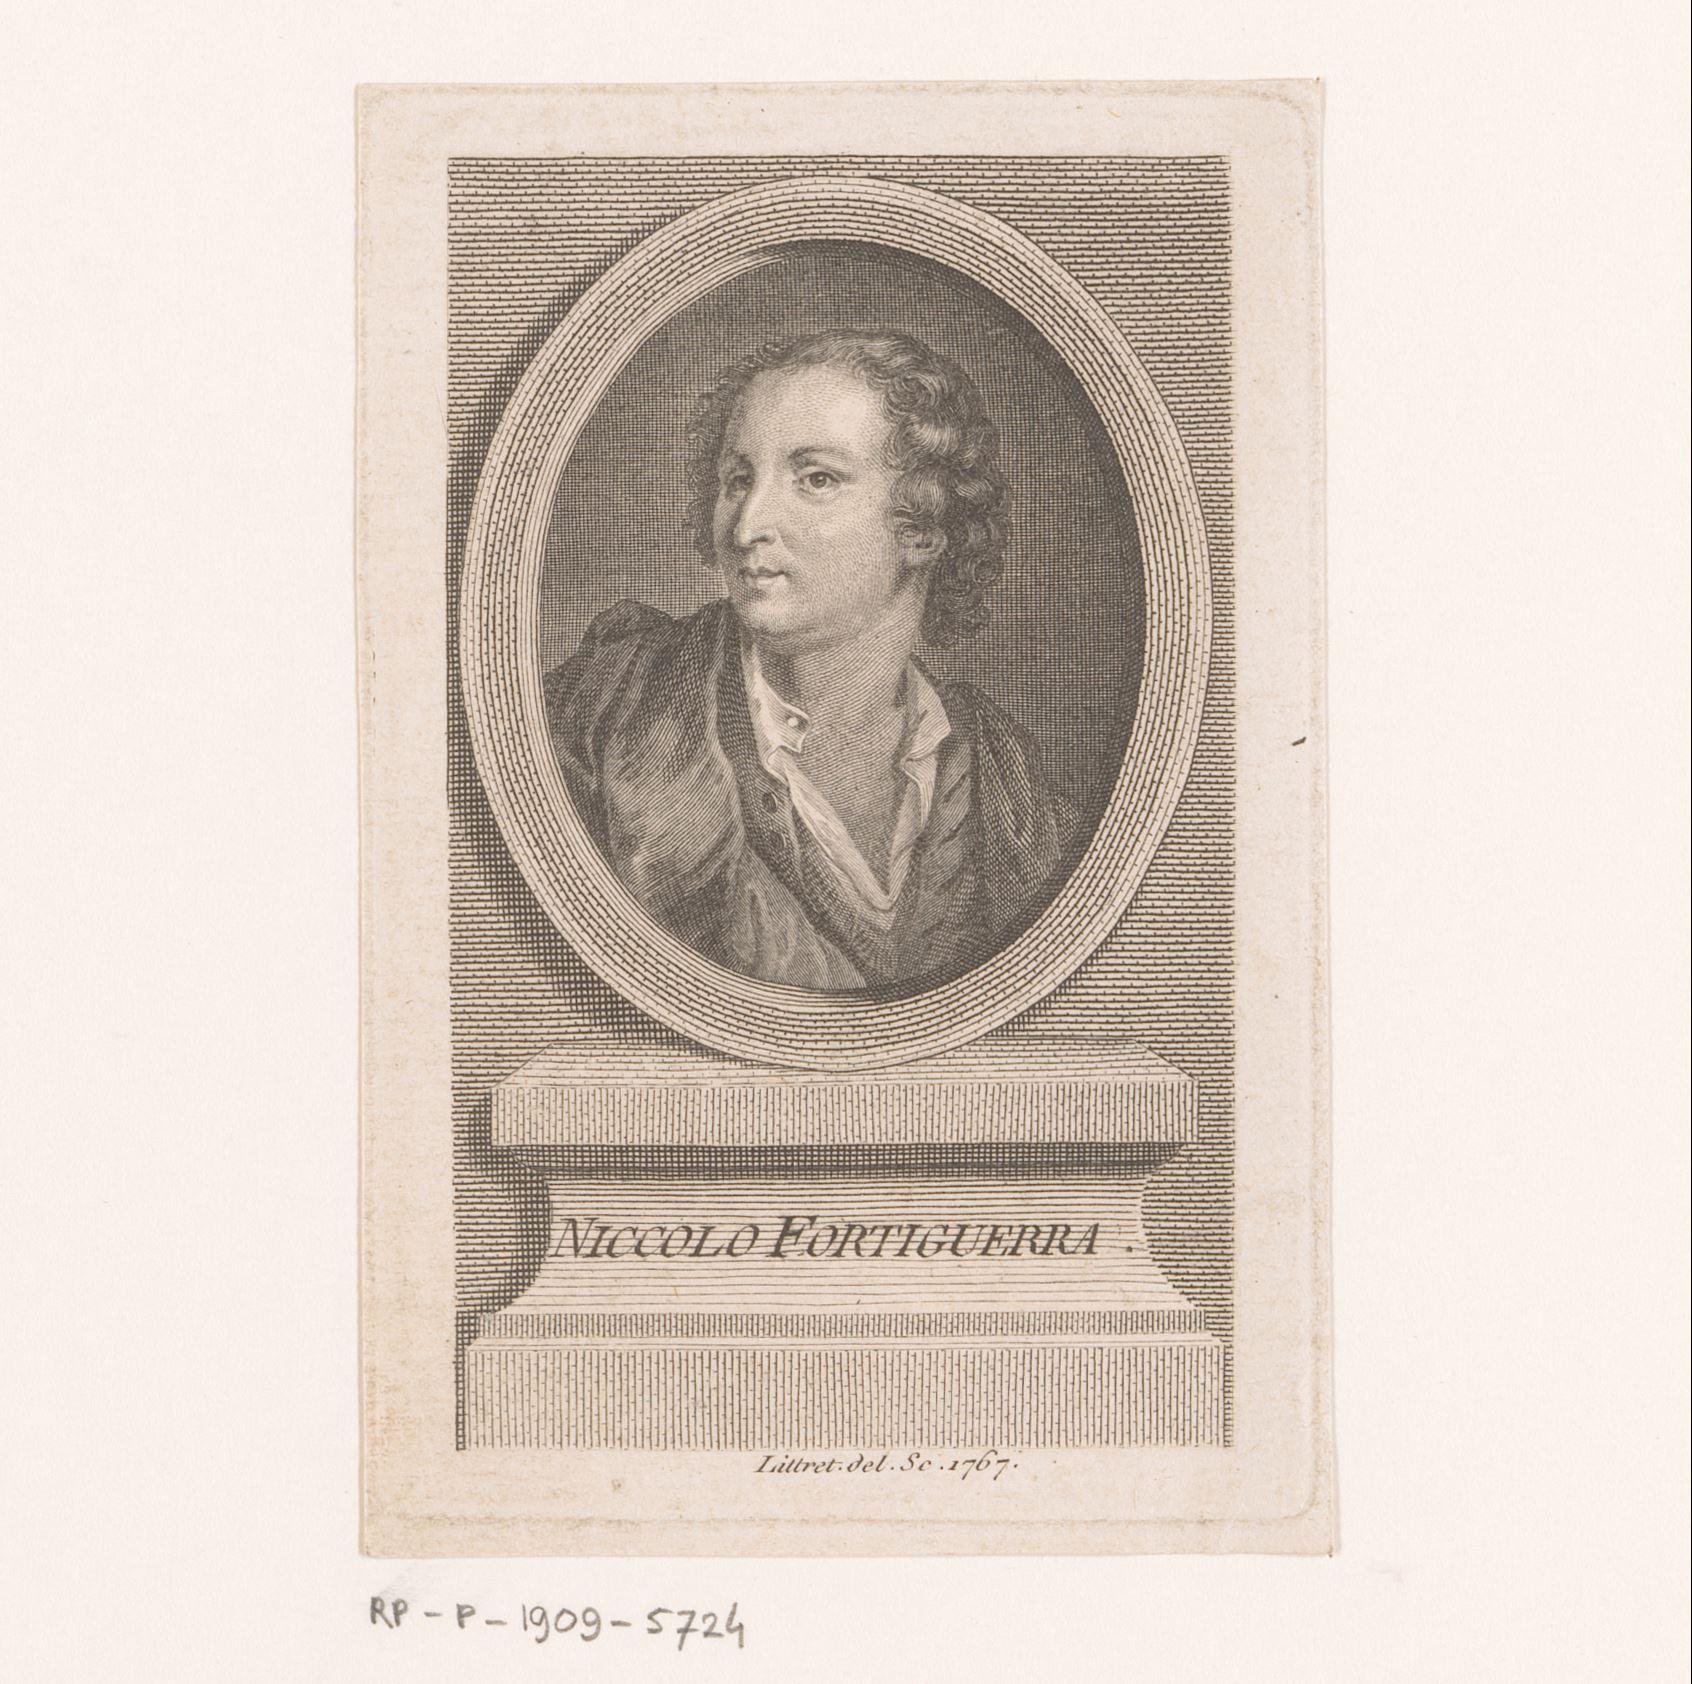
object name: print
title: Portret van Niccolò Fortiguerra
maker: claude antoine littret de montigny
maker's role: print maker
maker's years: 1735-1775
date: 1767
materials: paper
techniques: engraving, etching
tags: historical persons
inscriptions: collector's mark: Lugt 2228